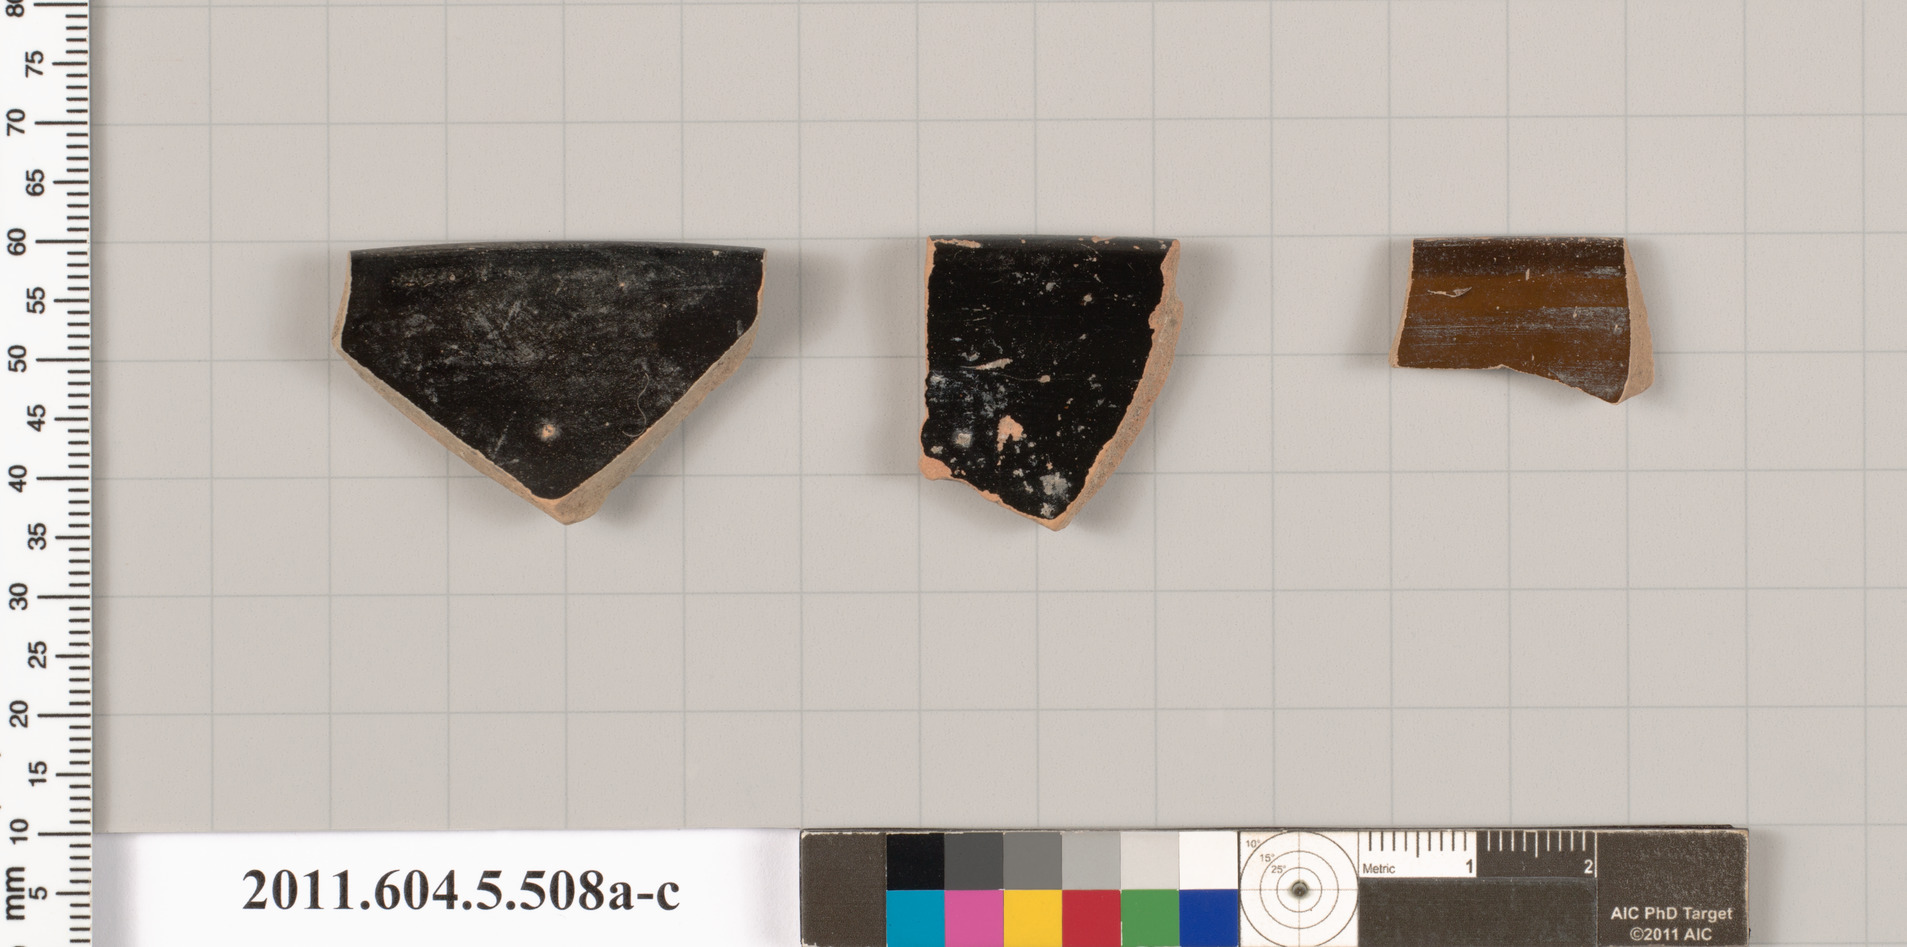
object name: kylix fragment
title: Terracotta rim fragments of kylikes (drinking cups)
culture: greek, attic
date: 600-401 BCE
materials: terracotta